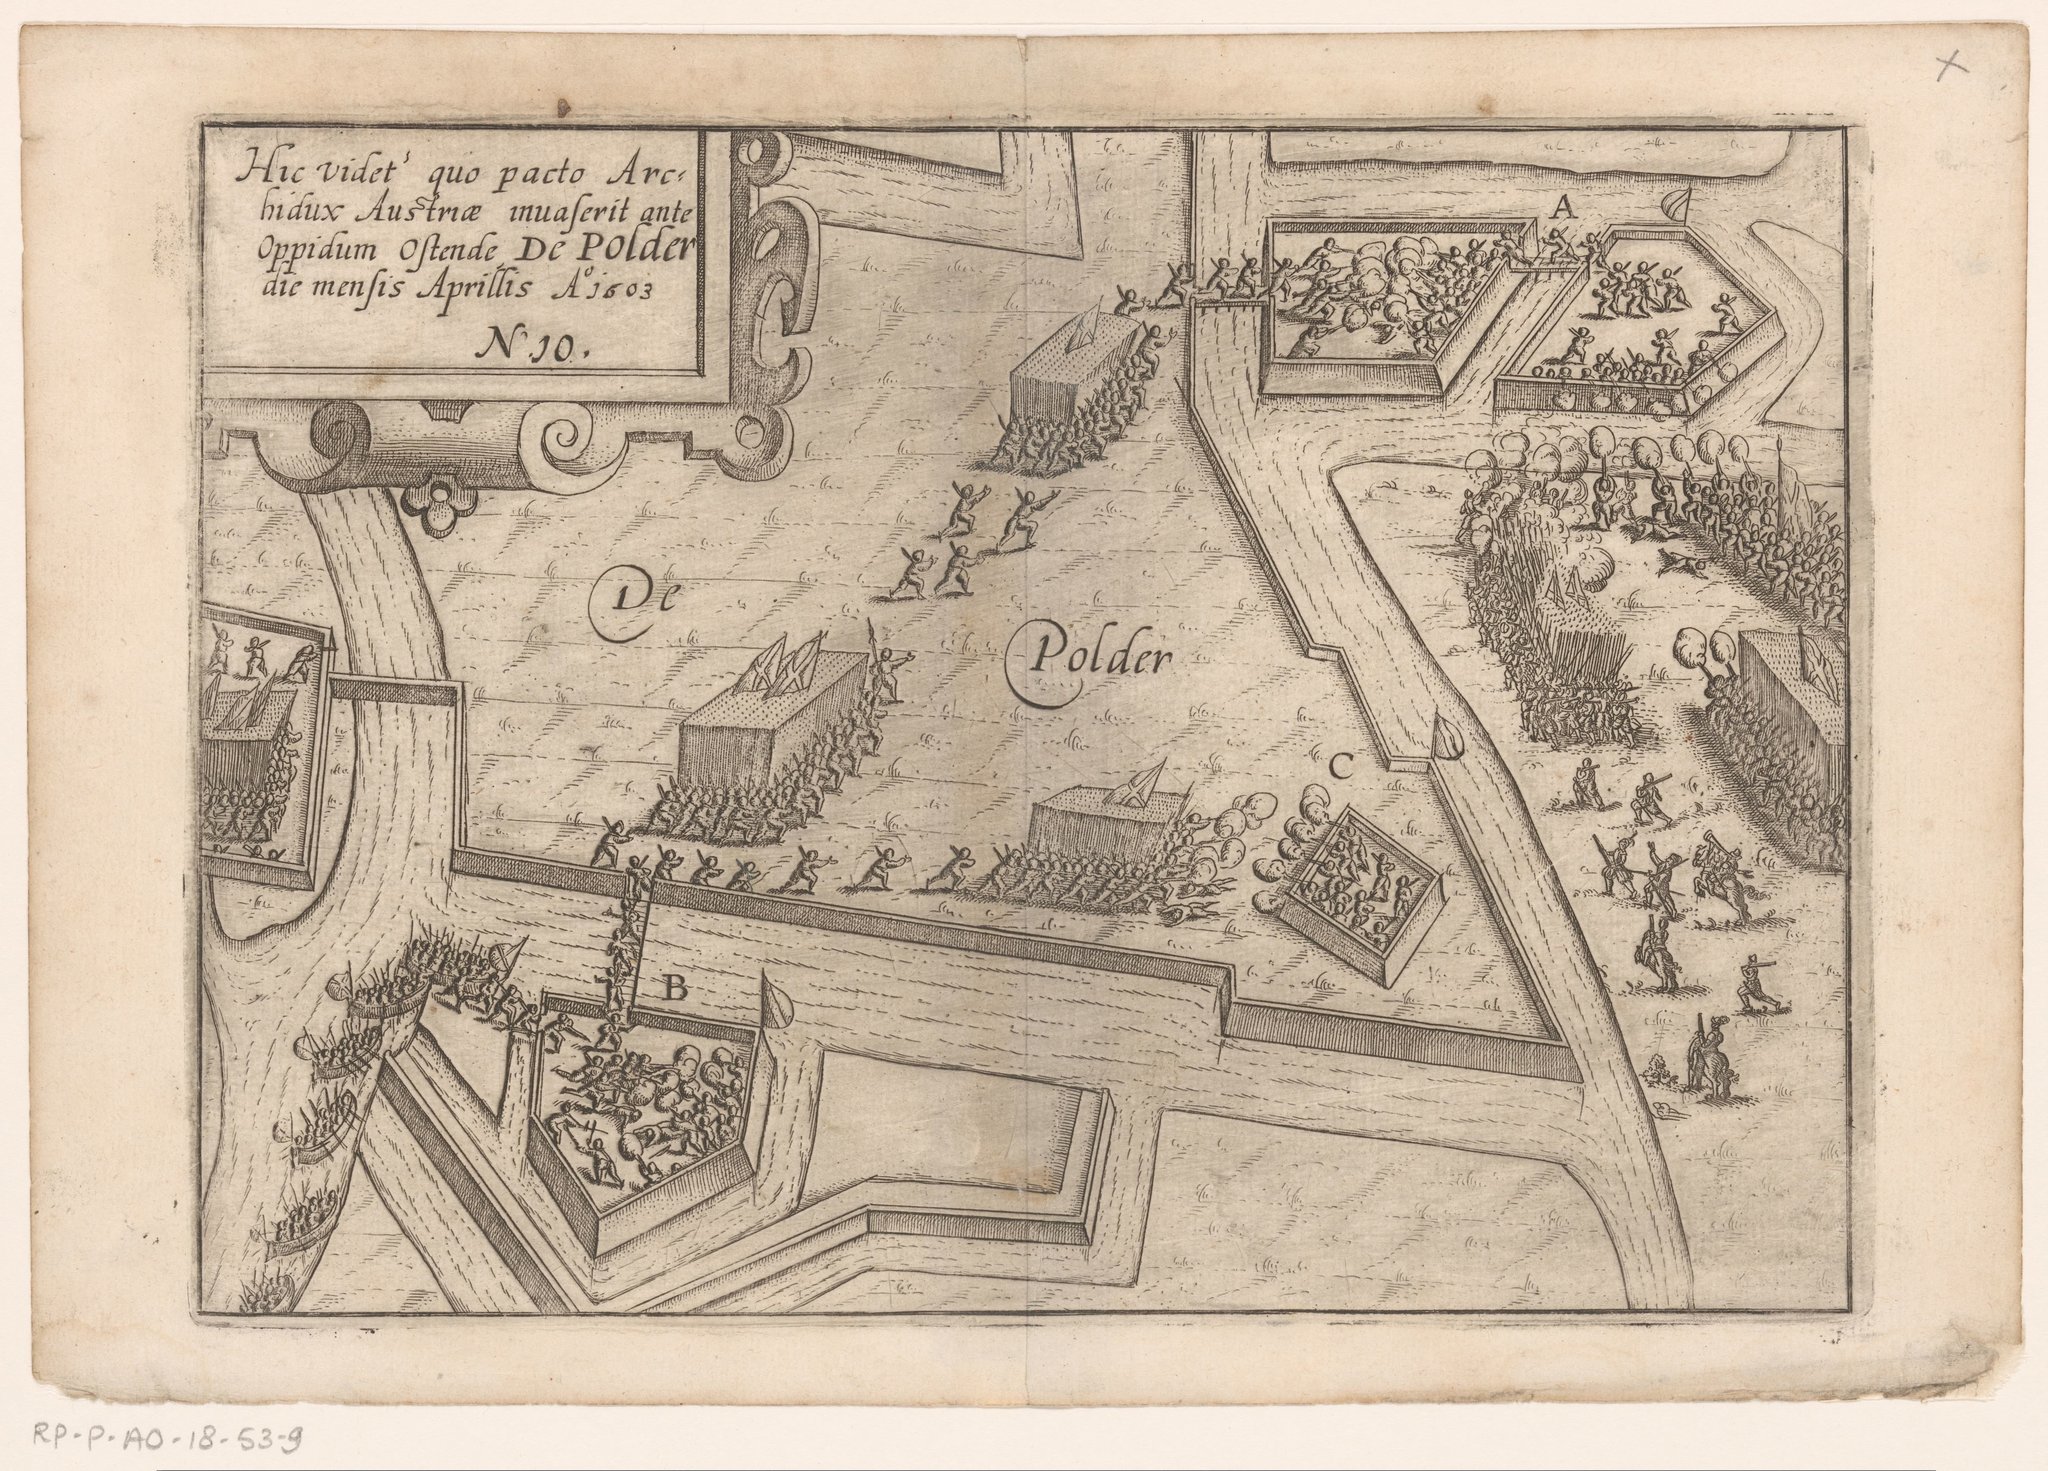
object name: print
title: Beleg van Oostende: verovering van de forten in de polder door het Spaanse leger, 1603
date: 1603-1604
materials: paper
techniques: etching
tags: siege, position war, battle (+ land forces)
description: Eerdere staat van prent ook gebruikt in contemporaine journalen van het beleg van Oostende uit 1604 (exemplaren in de collectie van de Rijksmuseum Research Library (326 F 10 en 326 F 11). En in: Haestens, Hendrick van. De Bloedige ende strenge Belegeringhe Der Stadt Oostende in Vlaenderen, Leiden: Hendrick van Haestens, 1613. Huidige staat van prent ook gebruikt in: Haestens, Hendrick van. La nouvelle Troye ou memorable histoire du siege d’Ostende. Leiden: Hendrick van Haestens, 1615.